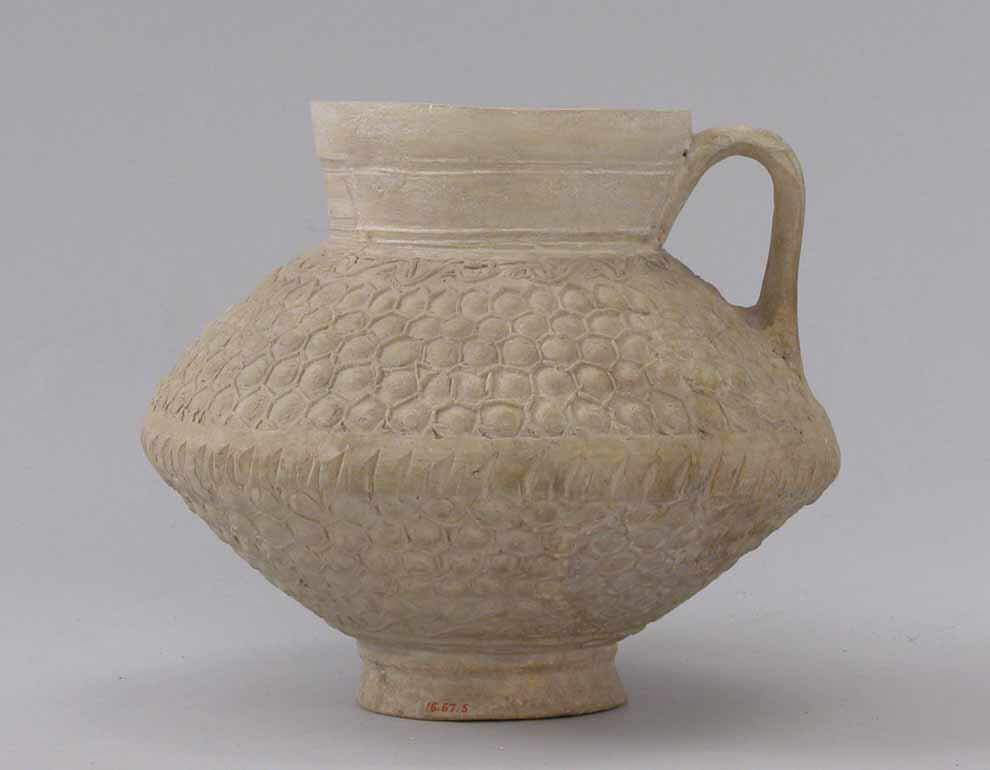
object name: jar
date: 1101-1200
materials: earthenware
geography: syria